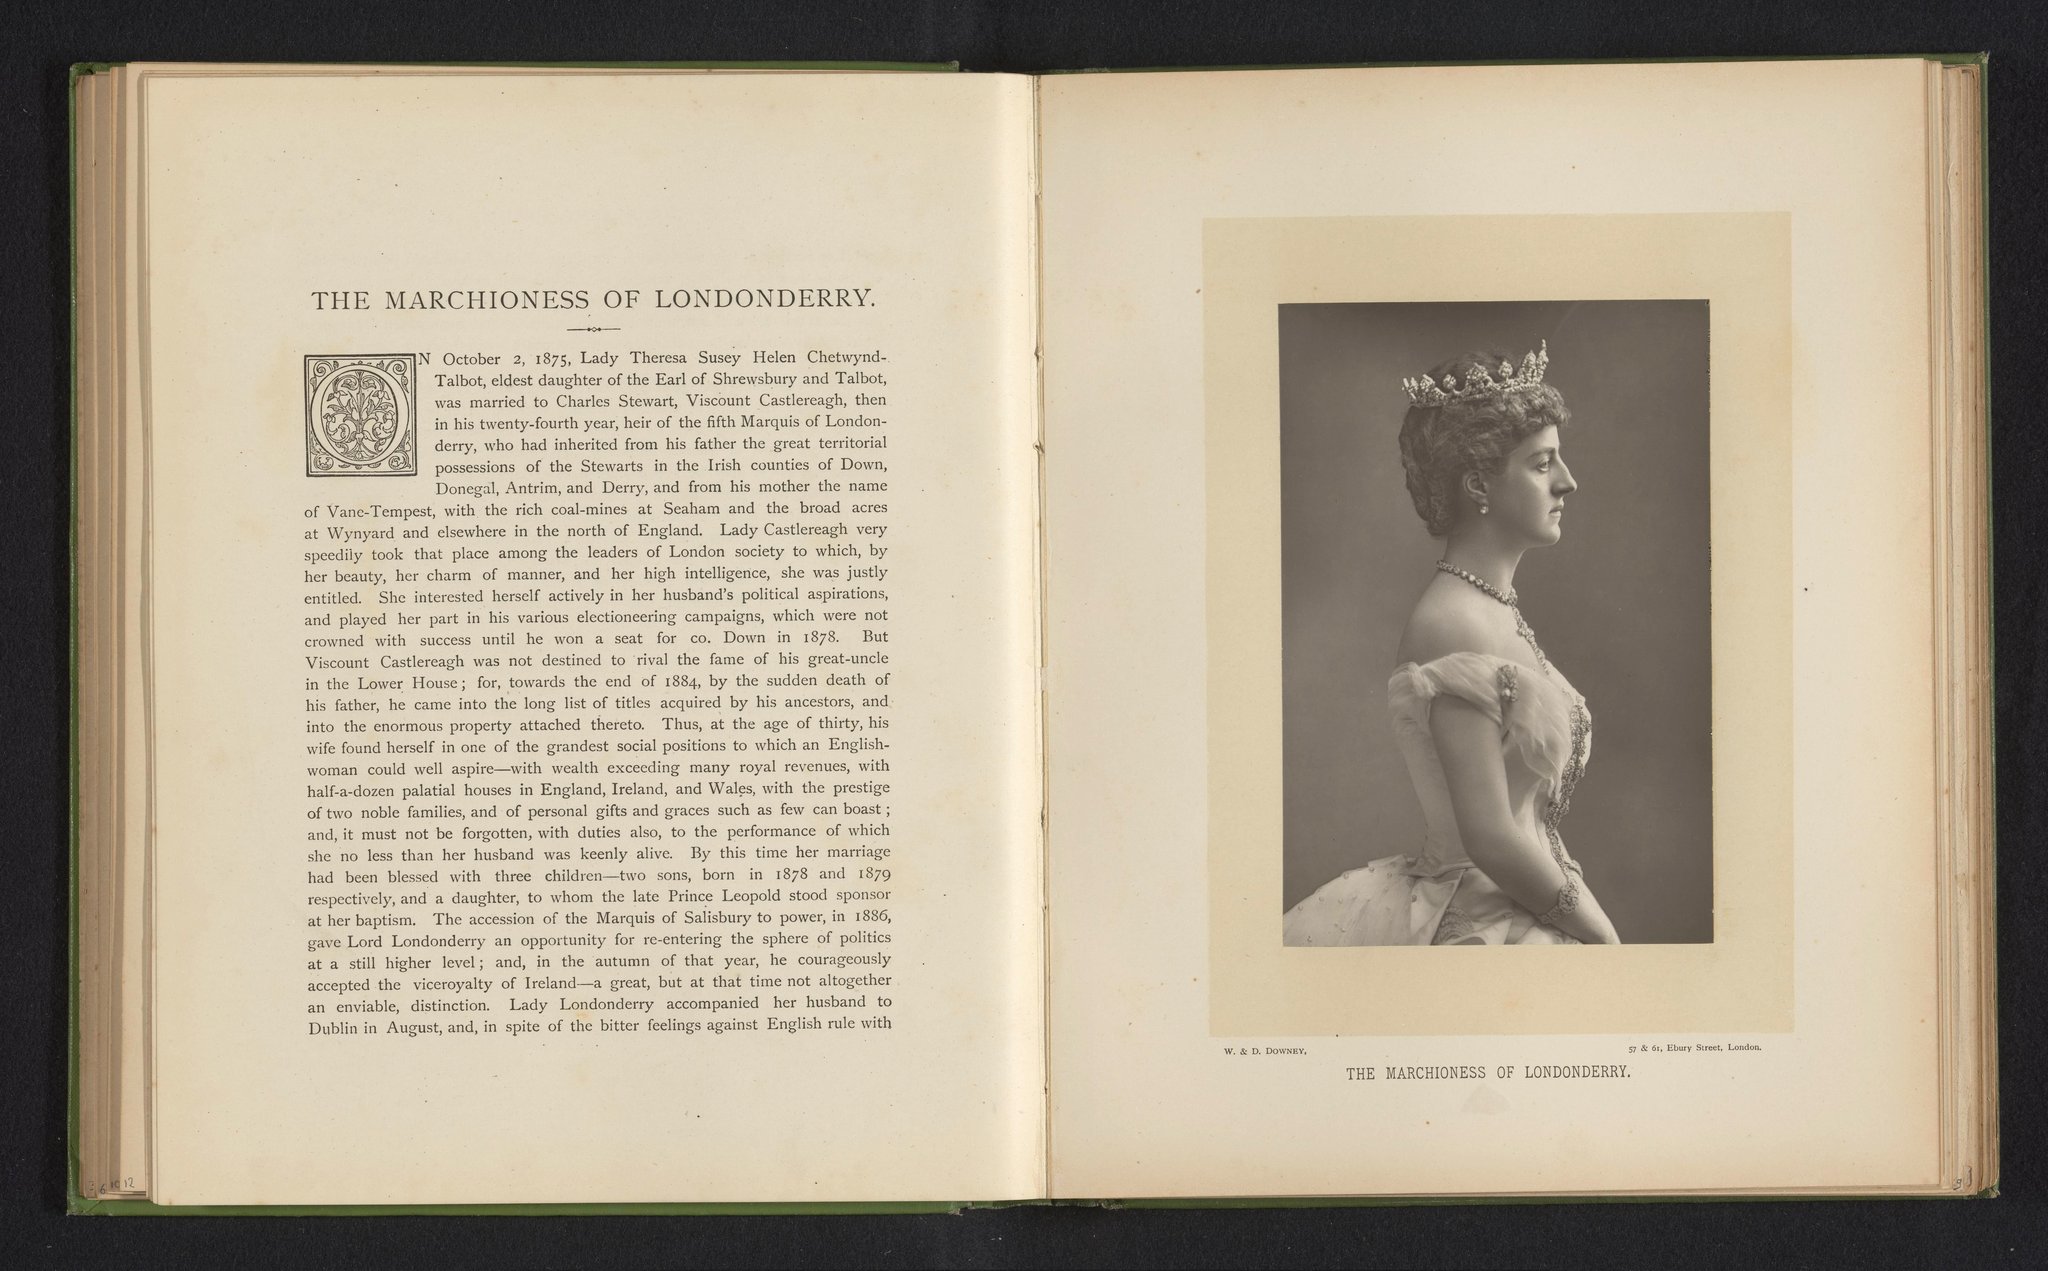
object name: photomechanical print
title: The Marchioness of Londonderry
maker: Anonymous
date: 1884-1894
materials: paper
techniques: woodburytype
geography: london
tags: ruler, sovereign - bb - female ruler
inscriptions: inscription: ‘57 & 61, Elbury Street, London.’